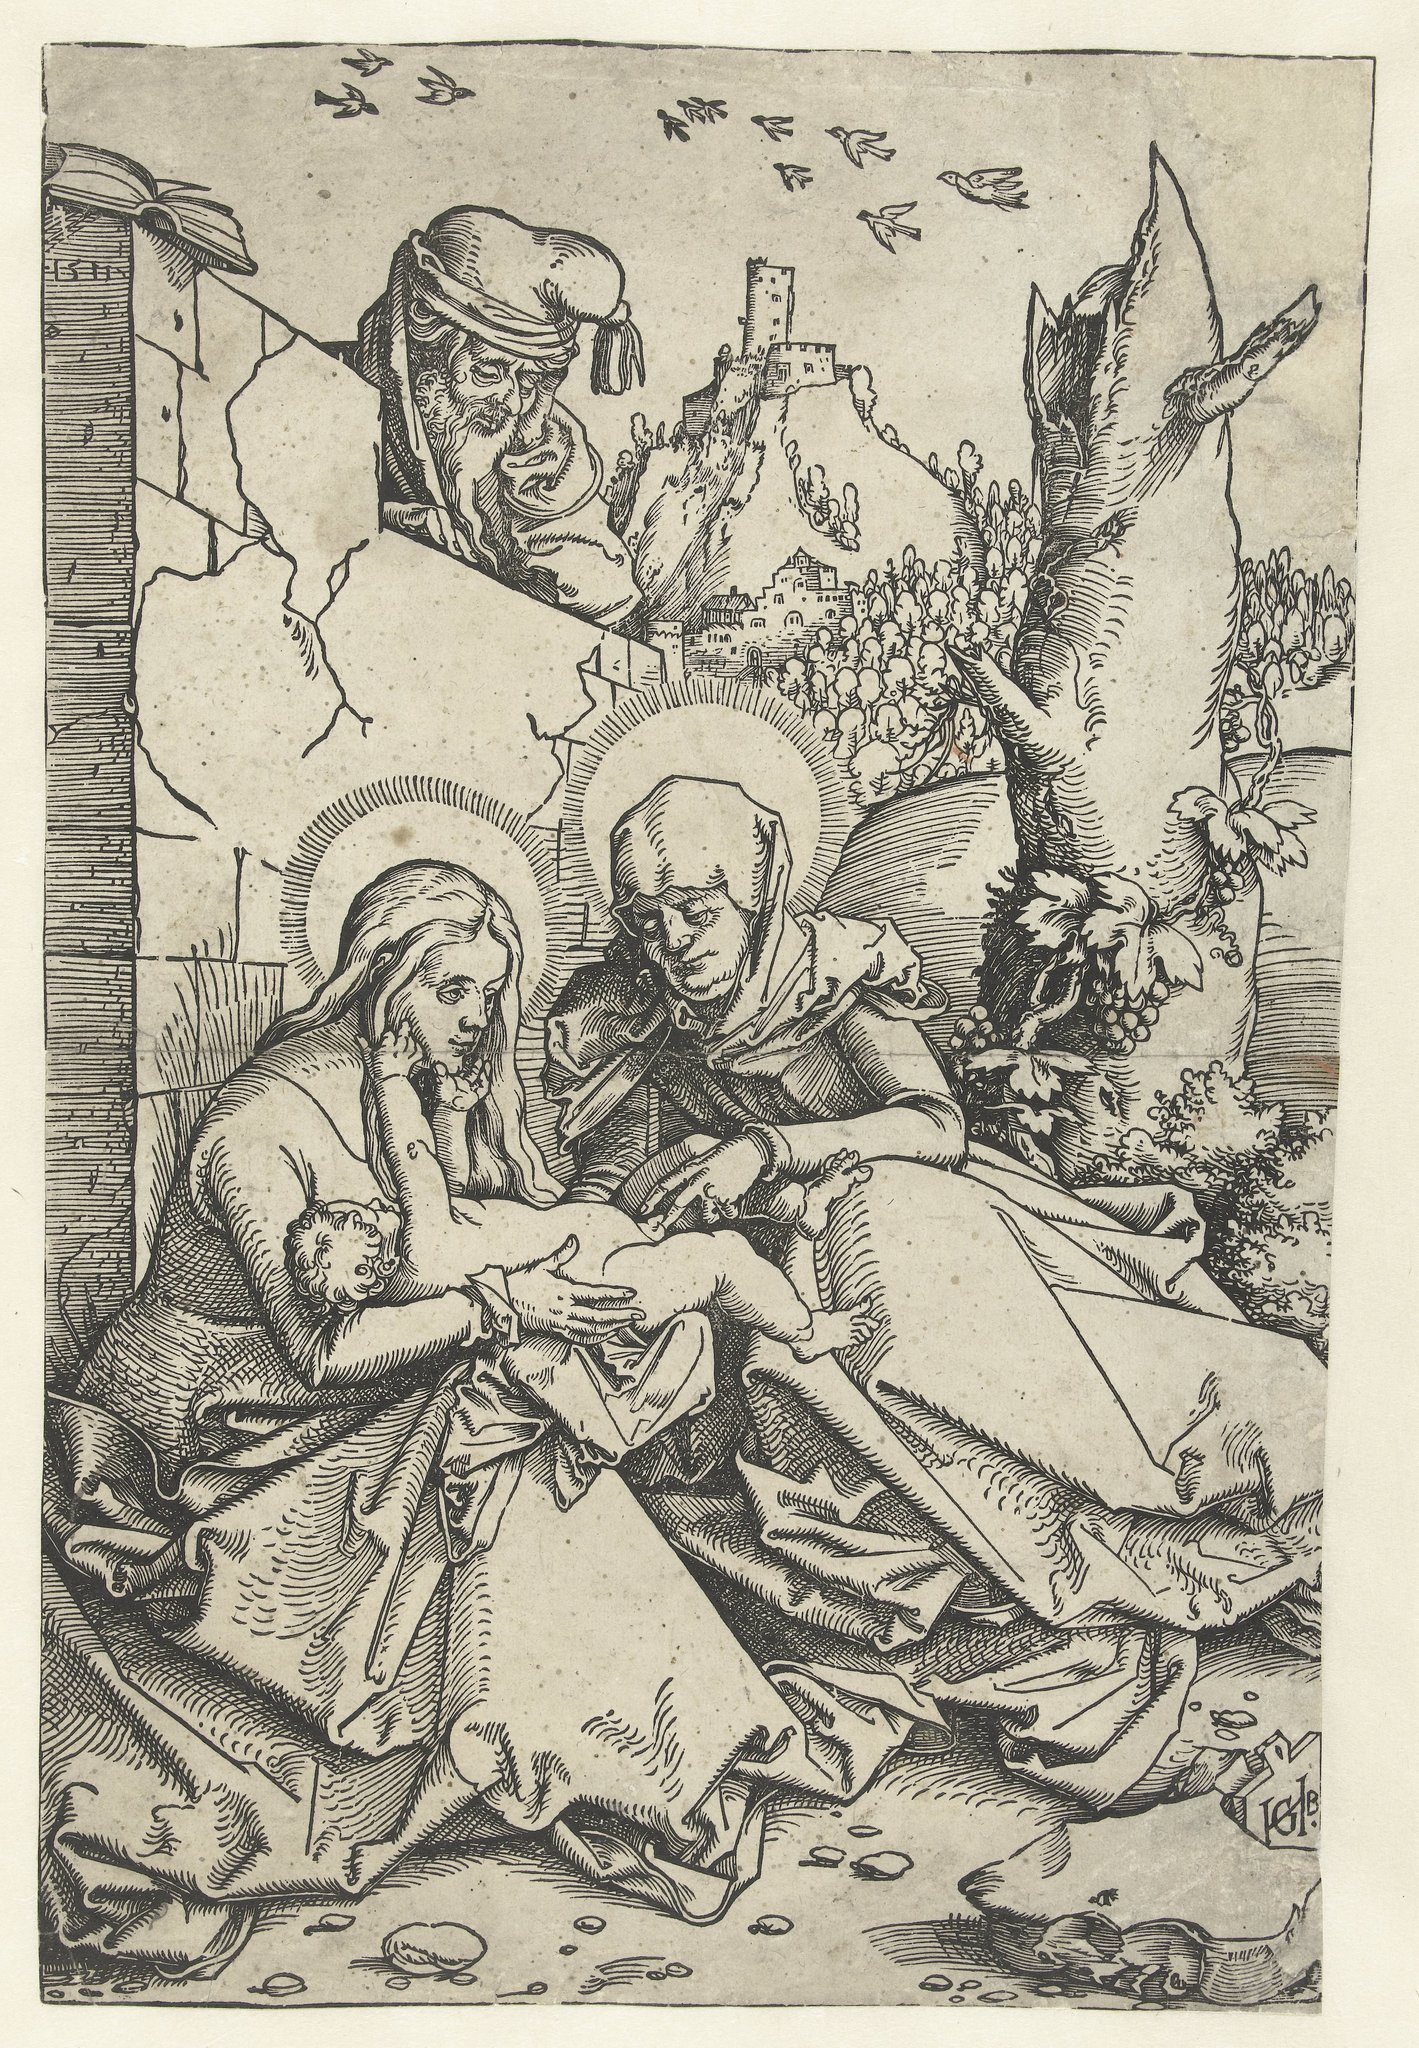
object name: print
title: Maria en Kind met Anna en Jozef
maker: hans baldung grien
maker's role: draughtsman, print maker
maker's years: 1484-1545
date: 1511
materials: paper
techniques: woodcut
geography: straatsburg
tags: 'anna selbdritt' with joseph present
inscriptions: collector's mark: Lugt 240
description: Maria zit op de grond voor een vervallen muur met het Kind in haar armen, naast haar zit de heilige Anna die haar handen uitsteekt naar het Christuskind. Jozef staat achter hen en kijkt toe over de muur. Naast Anna staat een dode boomstam waar een wijnrank zich omheen slingerd. Op de achtergrond licht een stad met een kasteel op een bergtop.